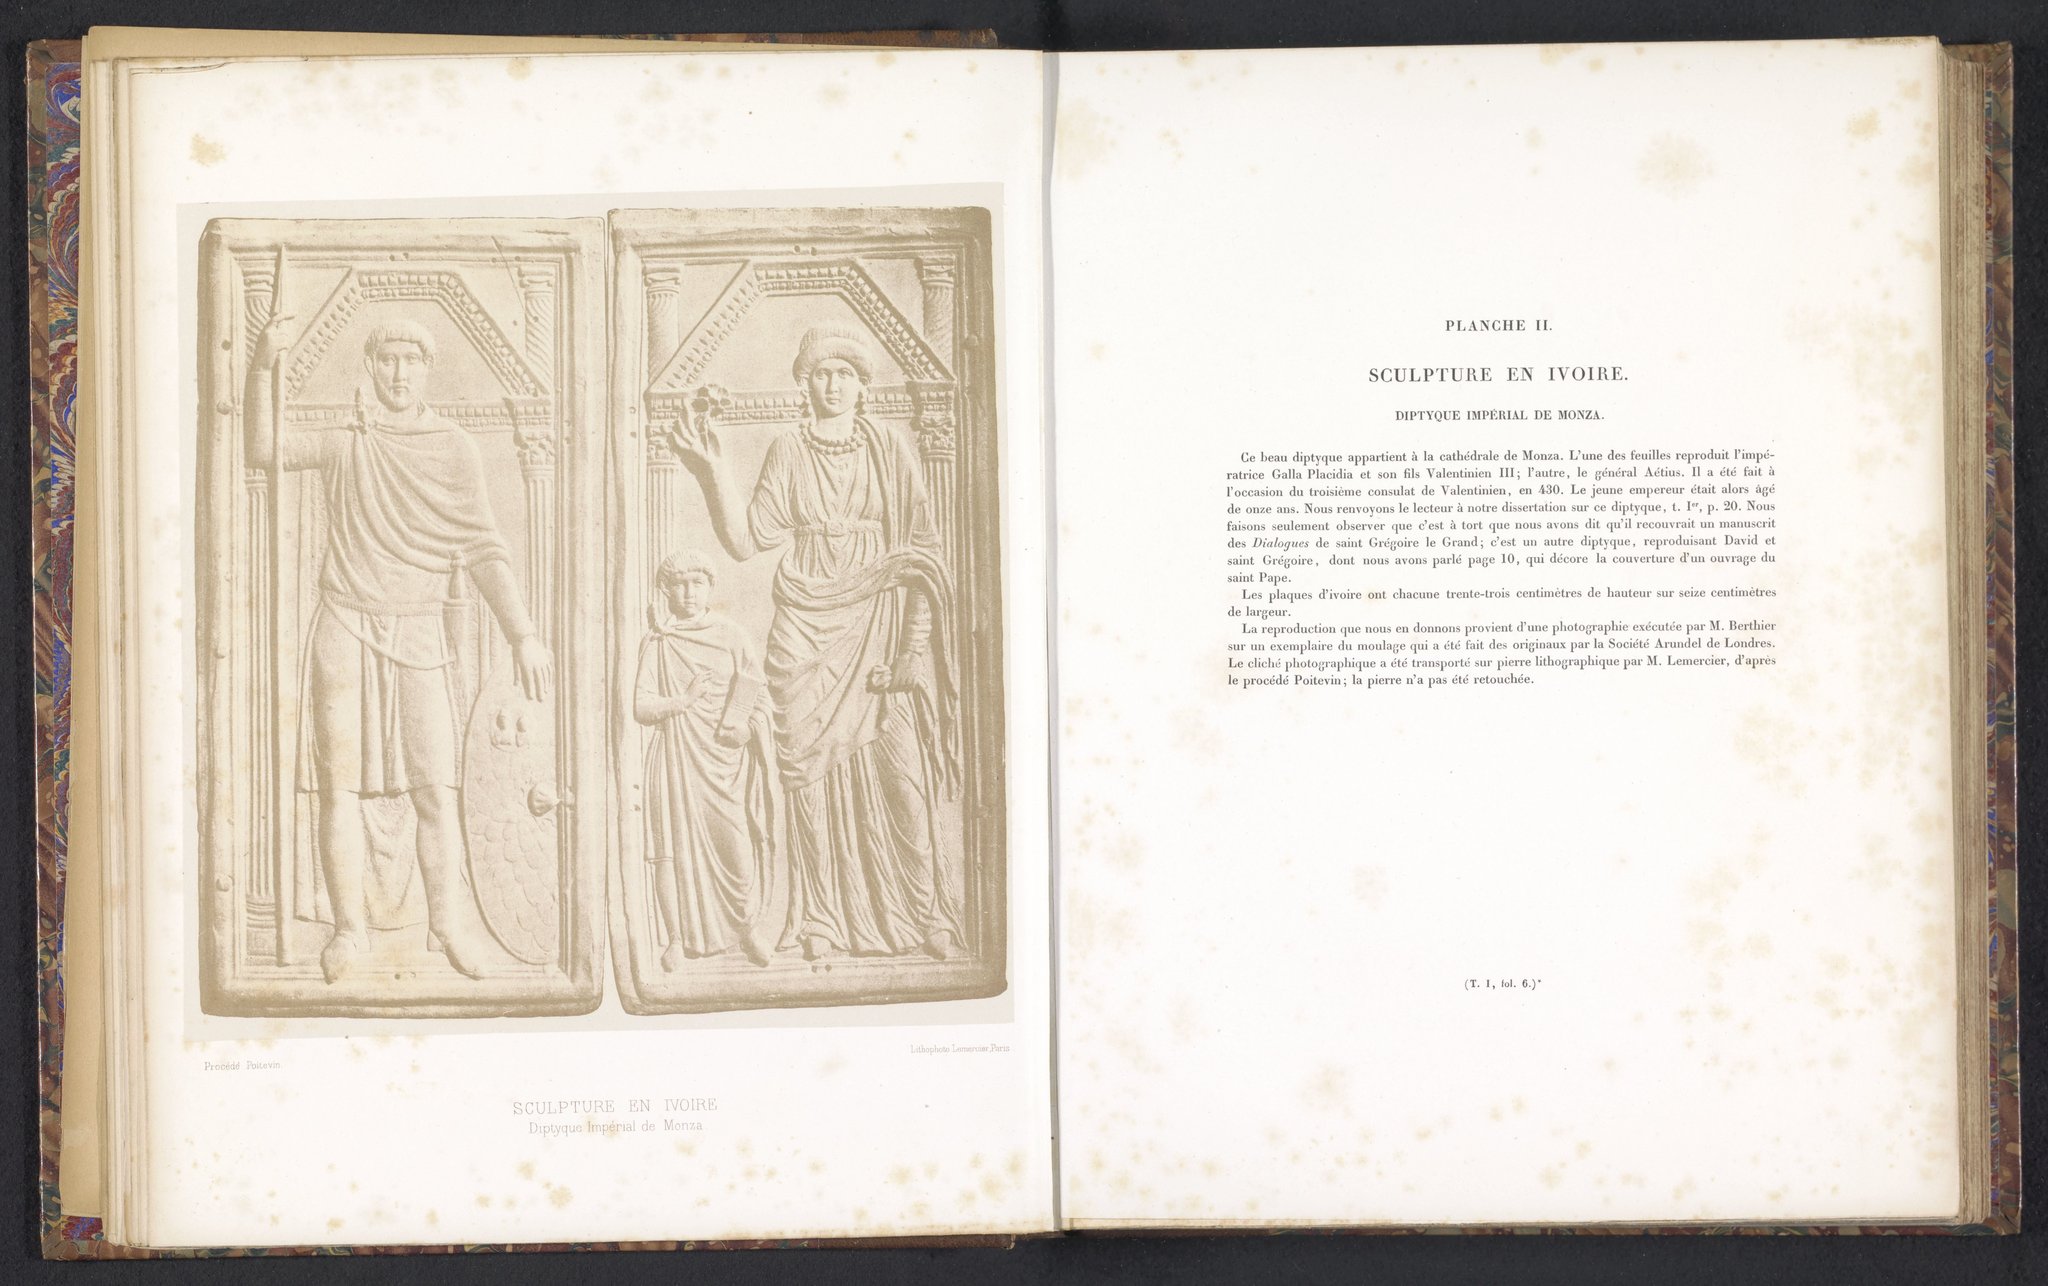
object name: photomechanical print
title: Ivoren diptiek van Flavius Stilicho met zijn vrouw en zoon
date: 1859-1864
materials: paper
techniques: photolithography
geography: paris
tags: commander-in-chief, general, marshal, mother and child(ren), woman and child(ren) (family group), sculpture (+ relief ~ sculpture)